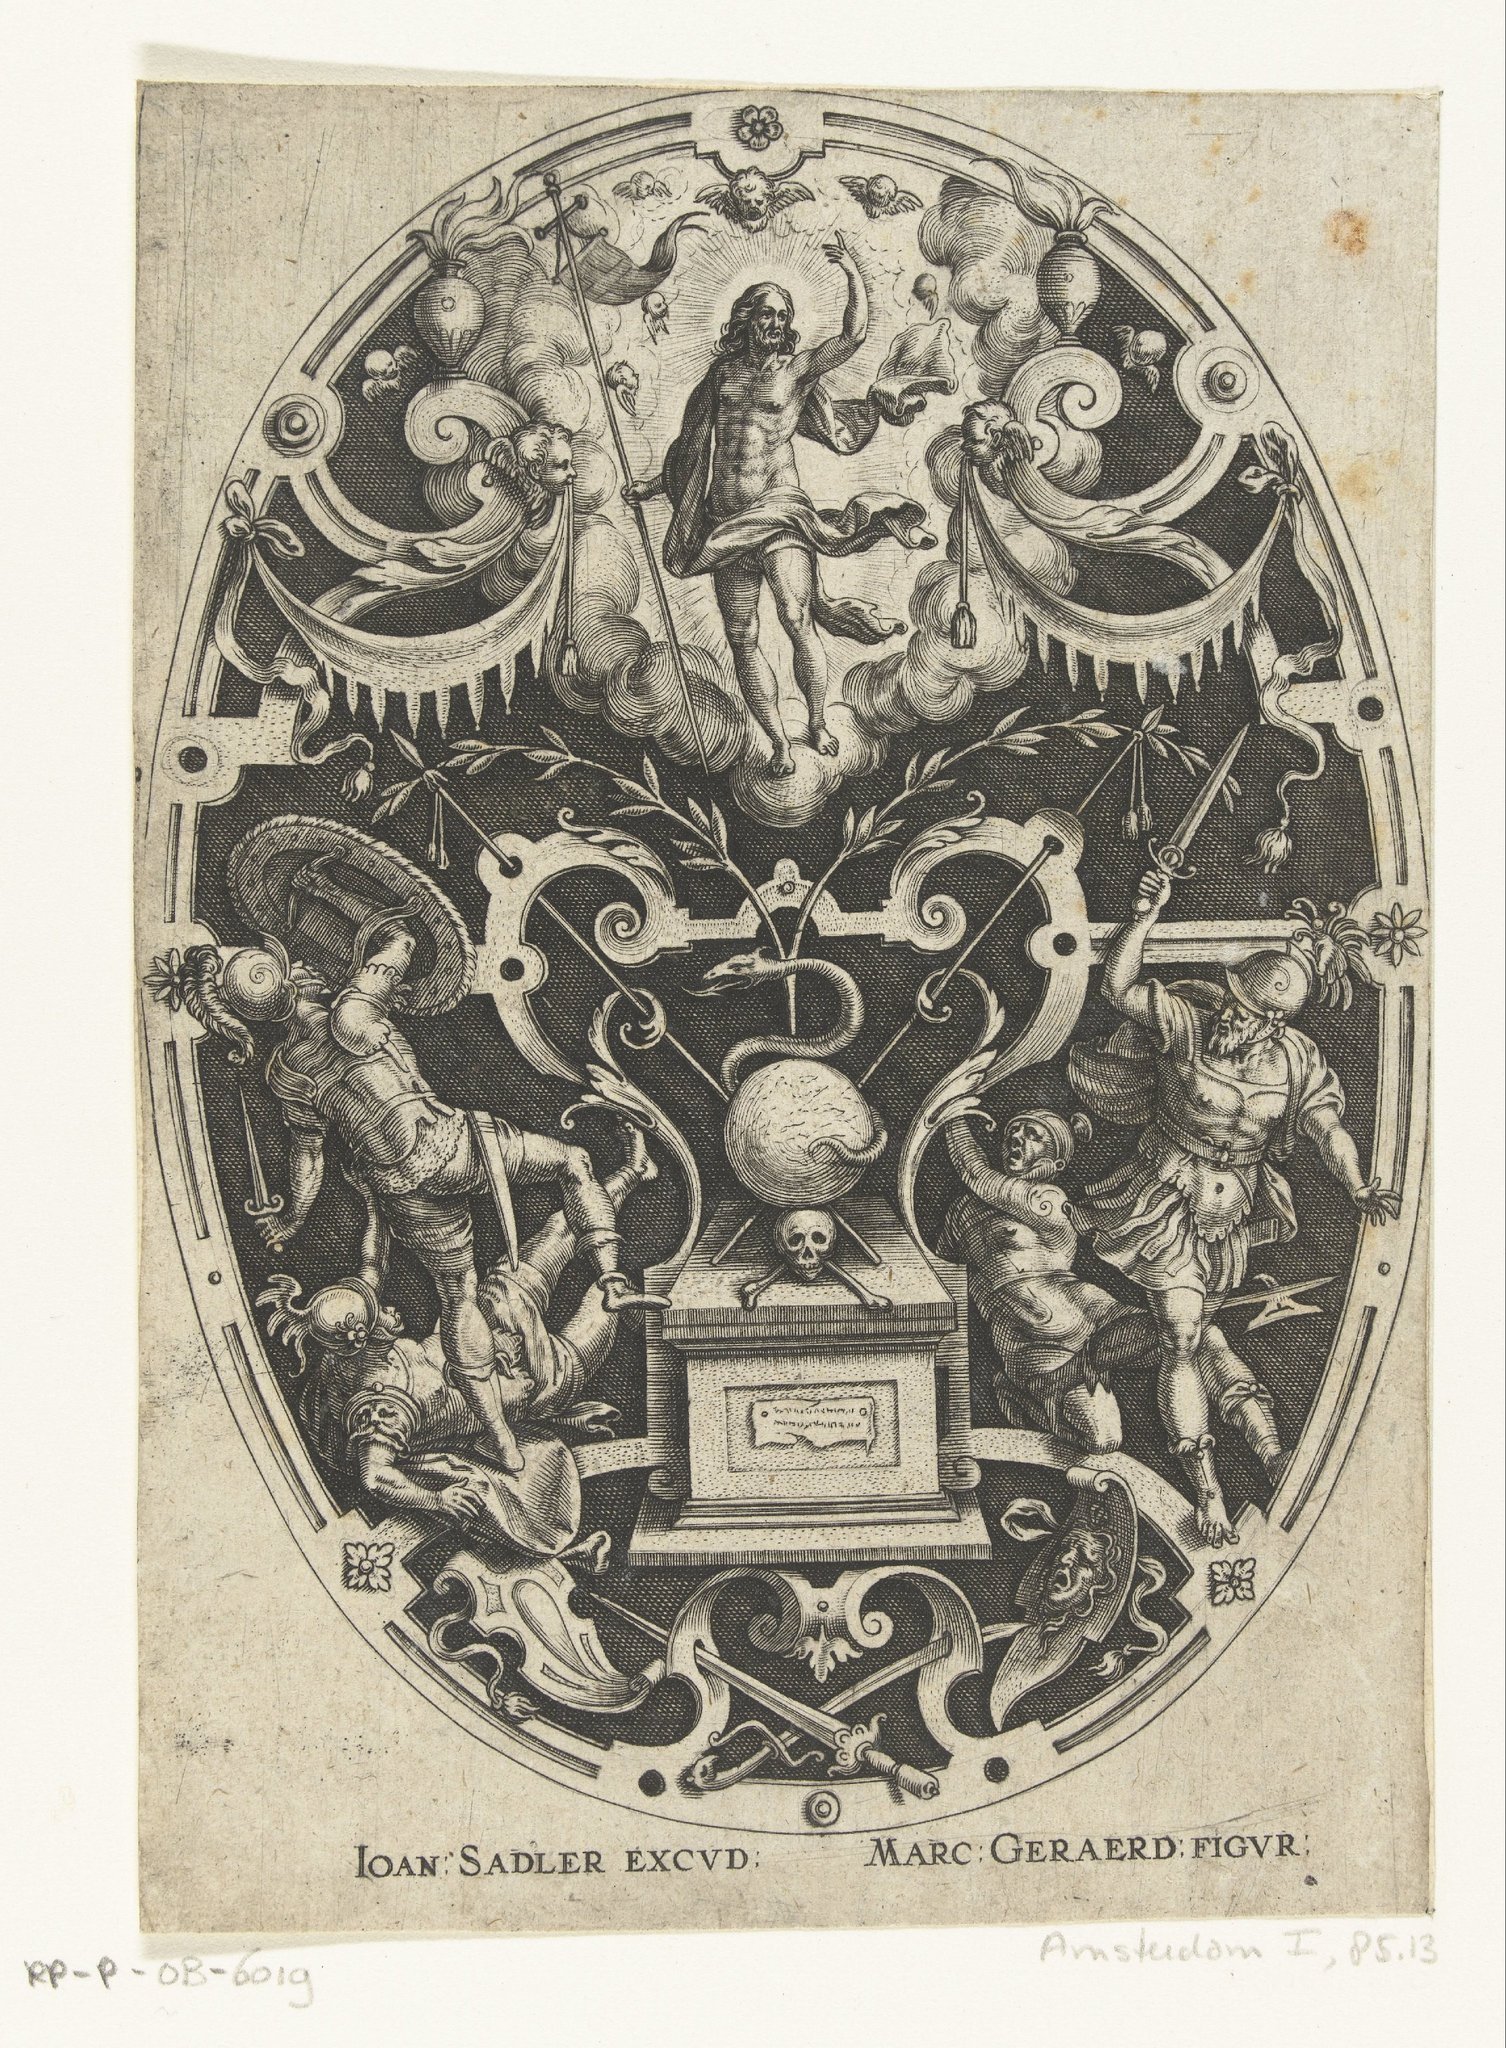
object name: print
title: Passio verbigenae quae redeptio Christ (...)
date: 1560-1600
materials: paper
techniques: engraving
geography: netherlands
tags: frightened and/or sleeping soldiers at the tomb of christ, christ, usually holding a banner, arises from the grave; often combined with sleeping and/or frightened soldiers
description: Uit serie van 14 ovalen met grotesken waarin scènes uit de passie zijn afgebeeld. Gearceerde achtergrond.